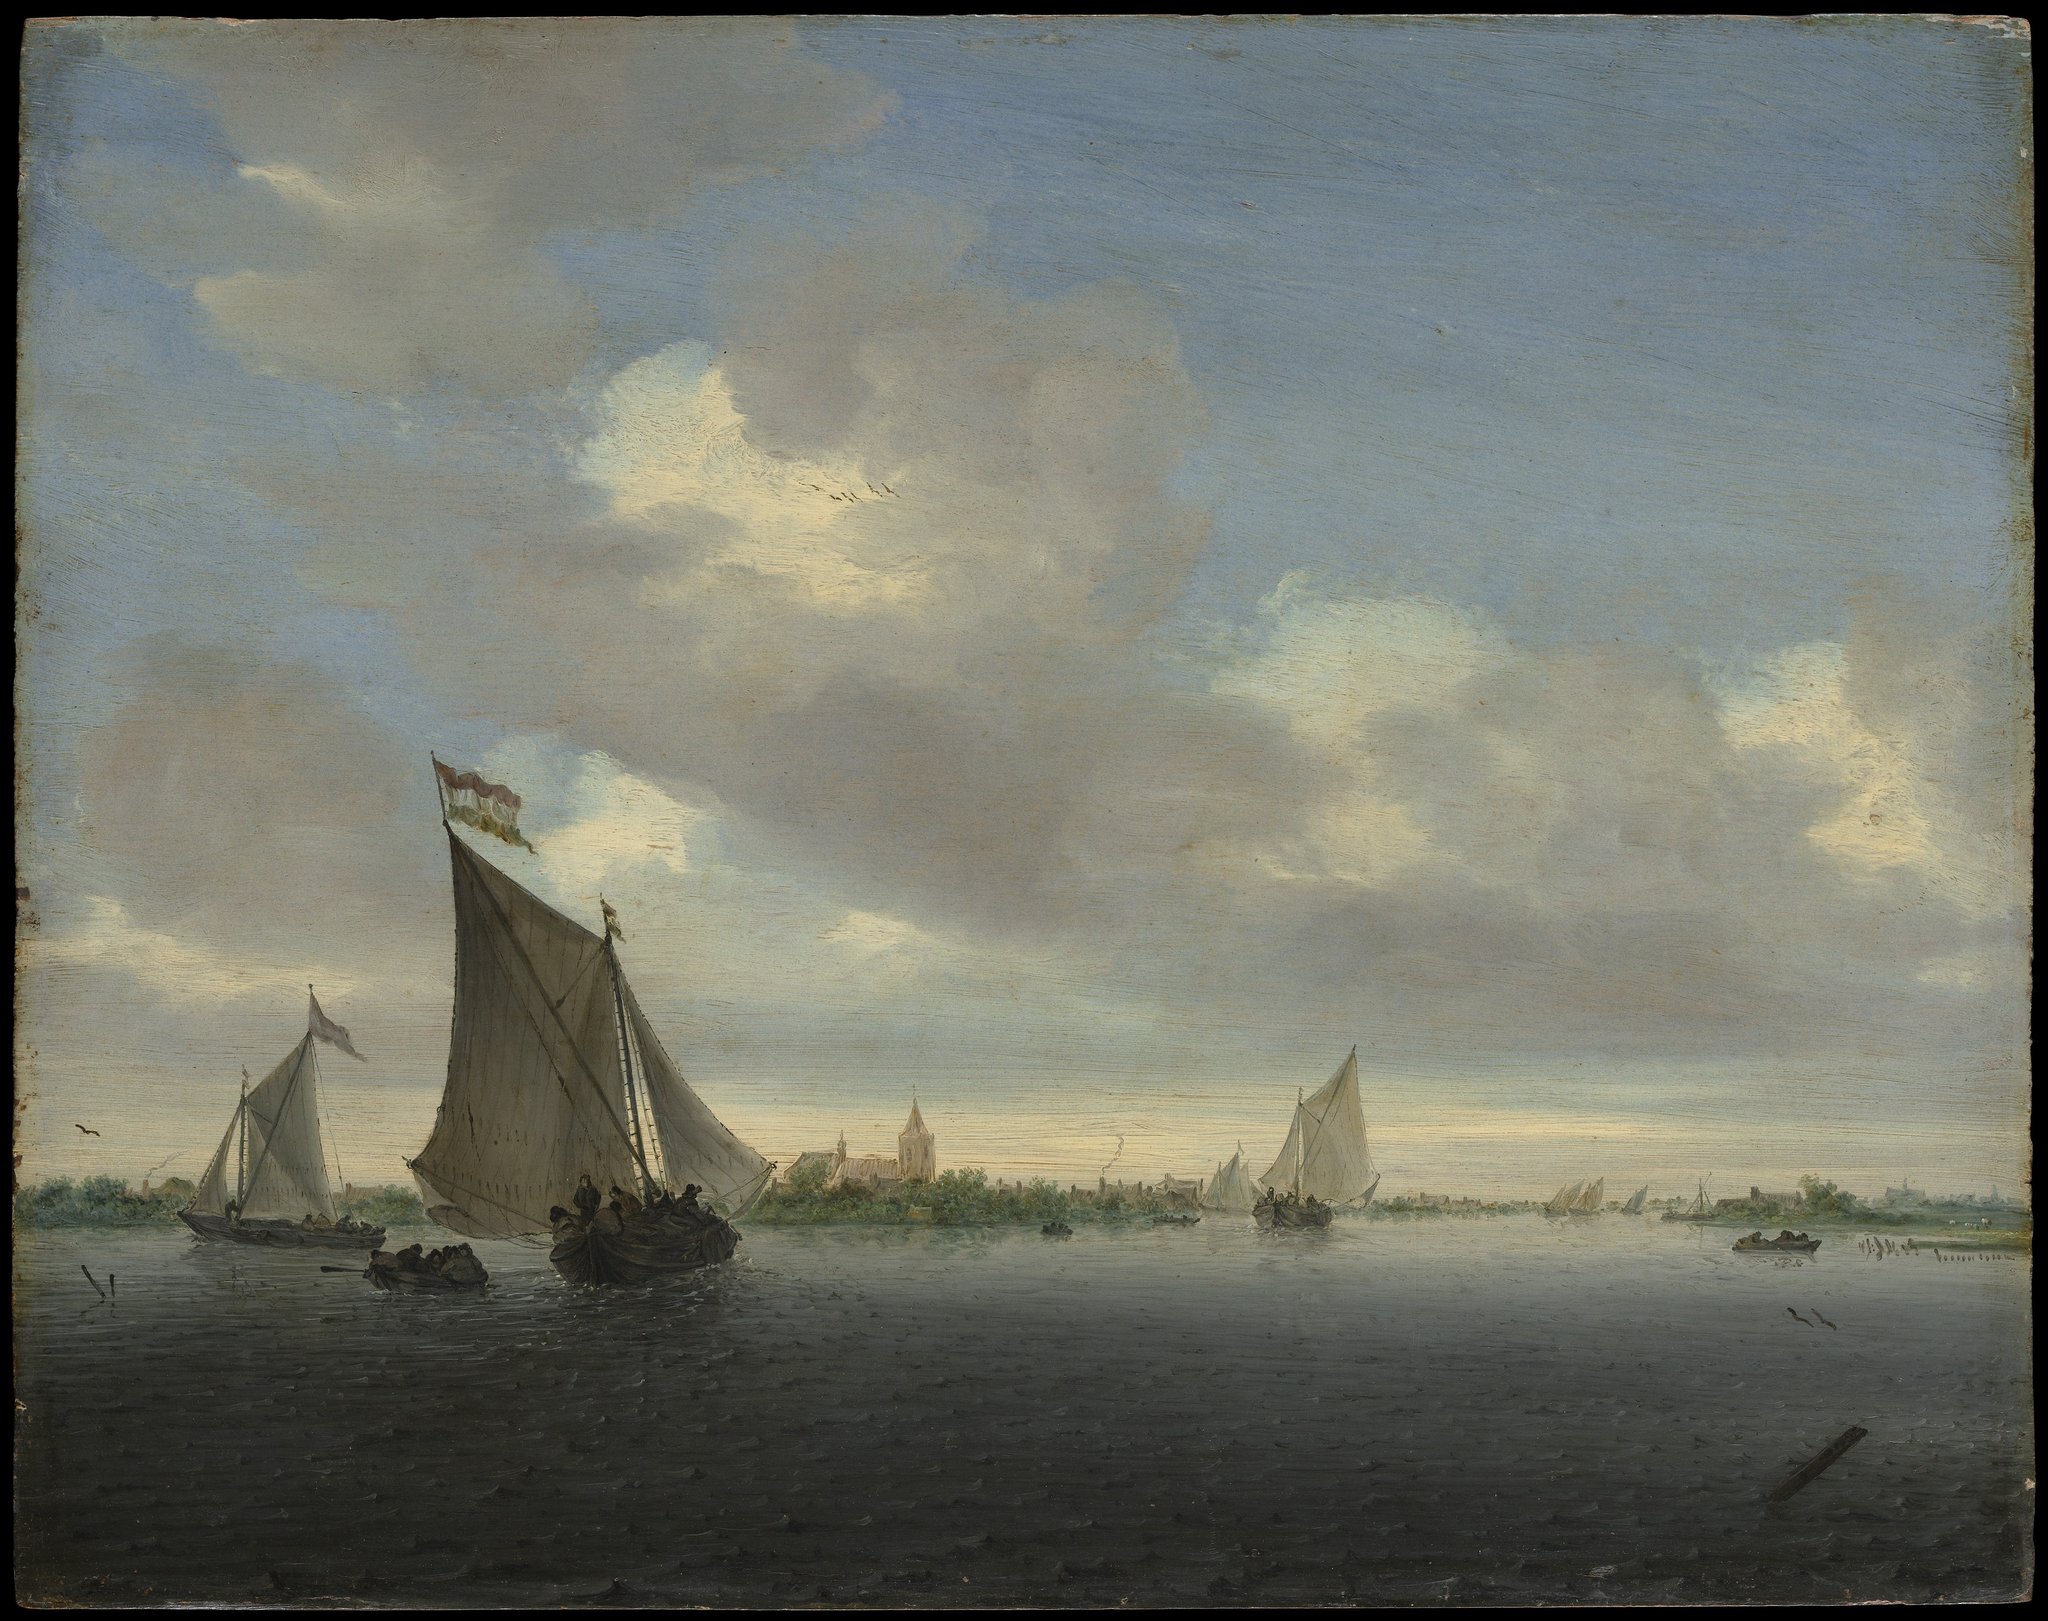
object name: painting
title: Marine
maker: salomon van ruysdael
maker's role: artist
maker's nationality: dutch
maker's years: 1600-1670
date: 1650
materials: oil, wood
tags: seascapes,ships